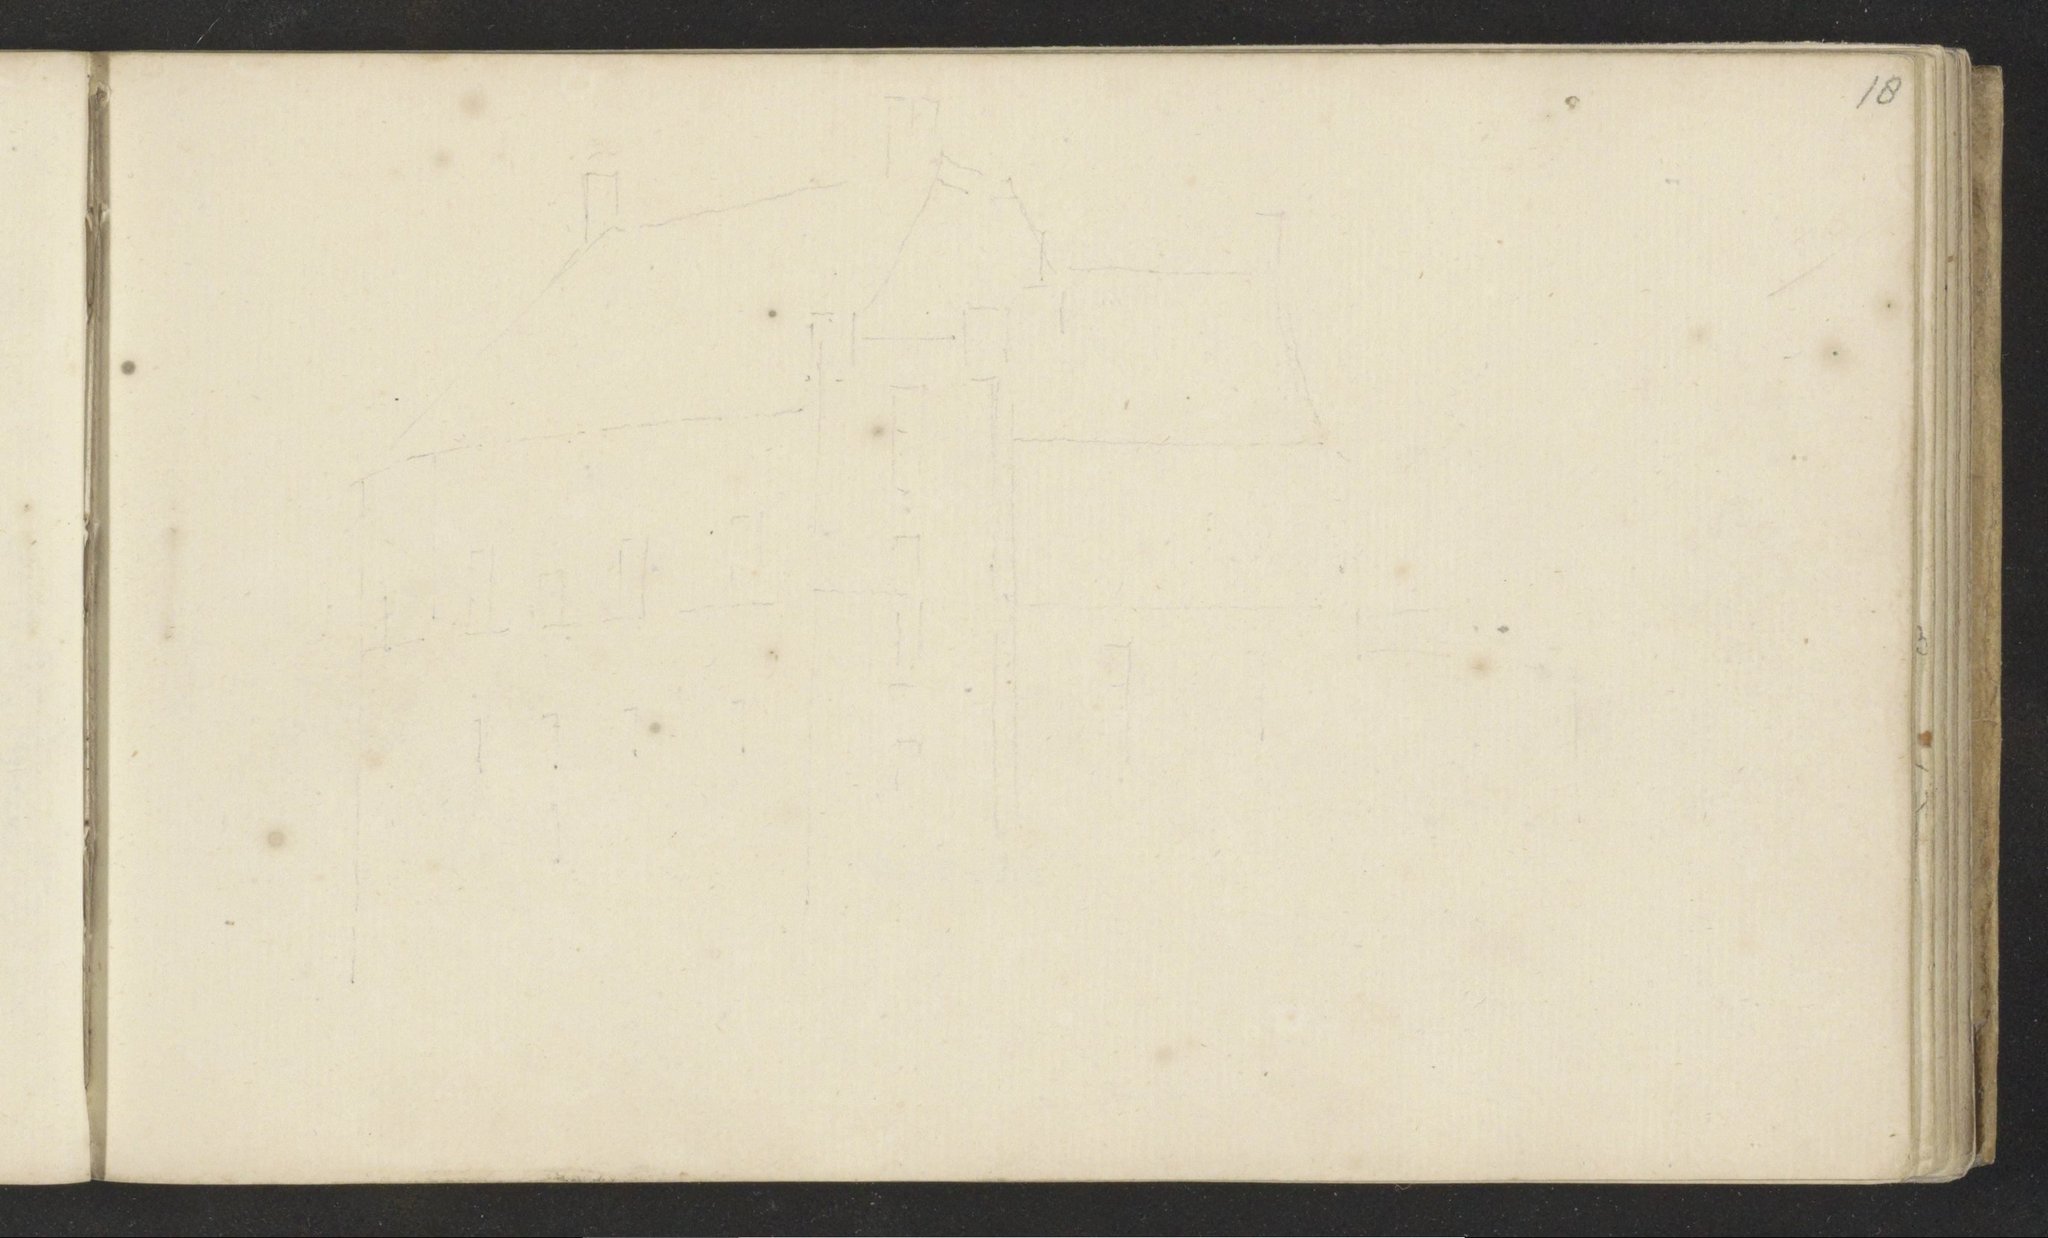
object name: sketchbook leaf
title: Kasteel Oud-Herlaer, gezien vanuit het zuidwesten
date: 1701-1759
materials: paper, pencil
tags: architecture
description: Aanzet voor een tekening van kasteel Oud-Herlaer, vanuit het zuidwesten gezien. Blad 18 recto uit een schetsboek met 65 bladen.